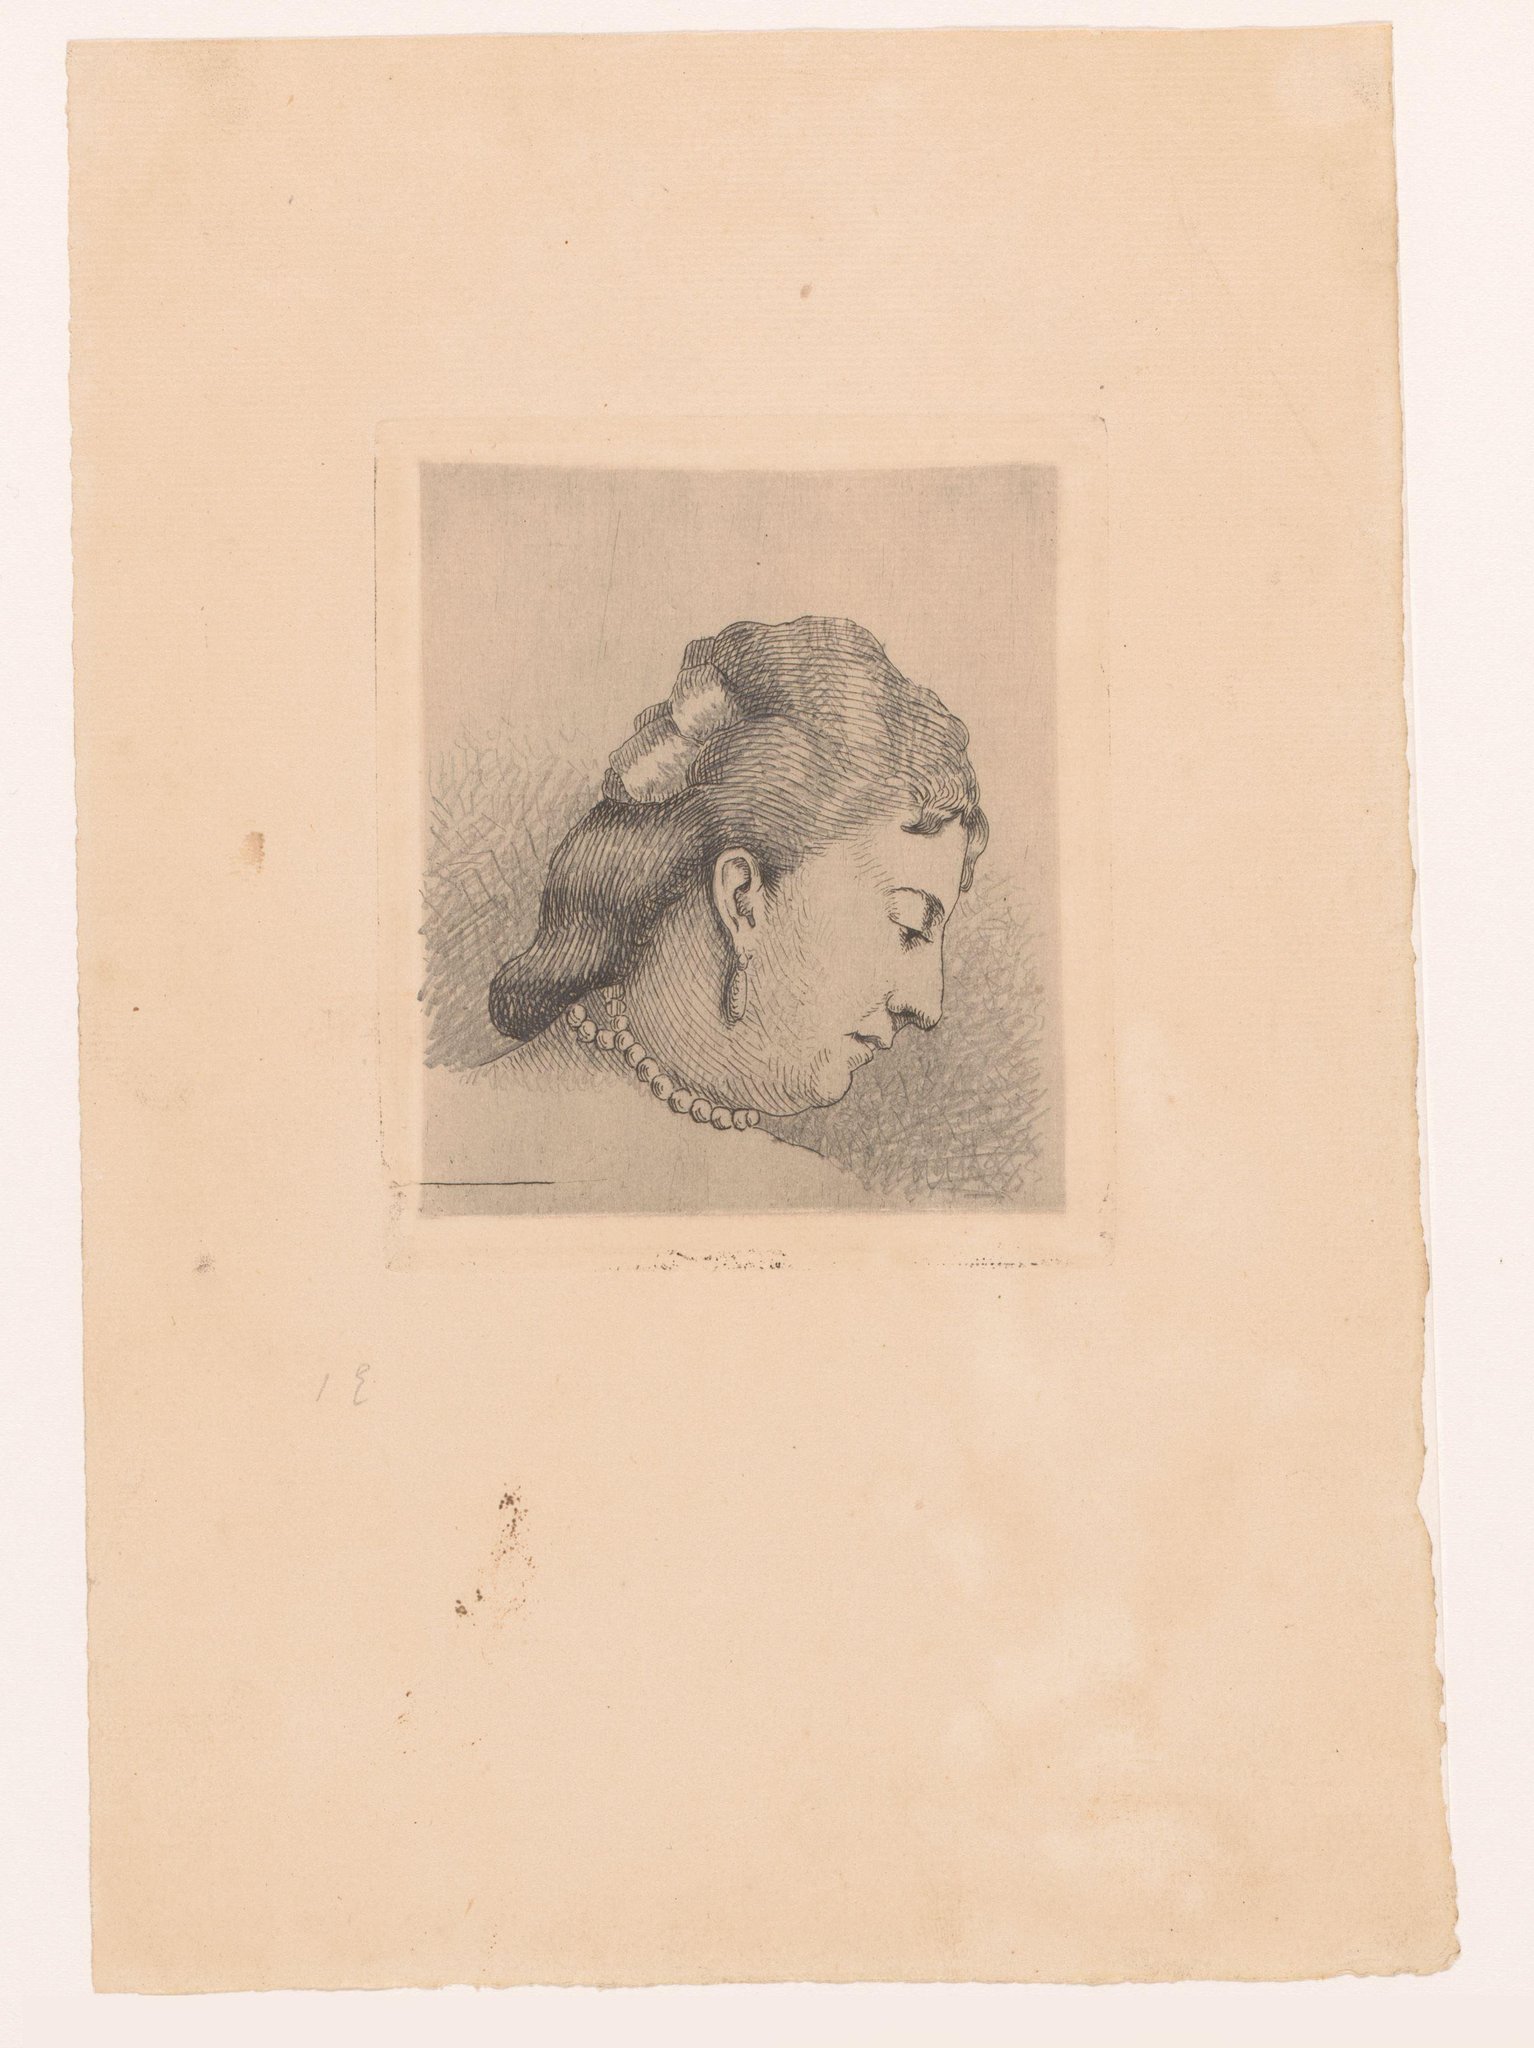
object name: print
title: Portret van een onbekende vrouw met parelketting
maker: g. laguesse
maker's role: print maker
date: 1877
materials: paper, pencil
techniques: drawing, etching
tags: anonymous historical person portrayed alone - bb - woman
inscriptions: annotation: ‘1 E’, collector's mark: Lugt 2228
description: Sterfdatum prentmaker onbekend. Derhalve is voor bepaling van de rechten van dit object de vervaardigingsdatum aangehouden.